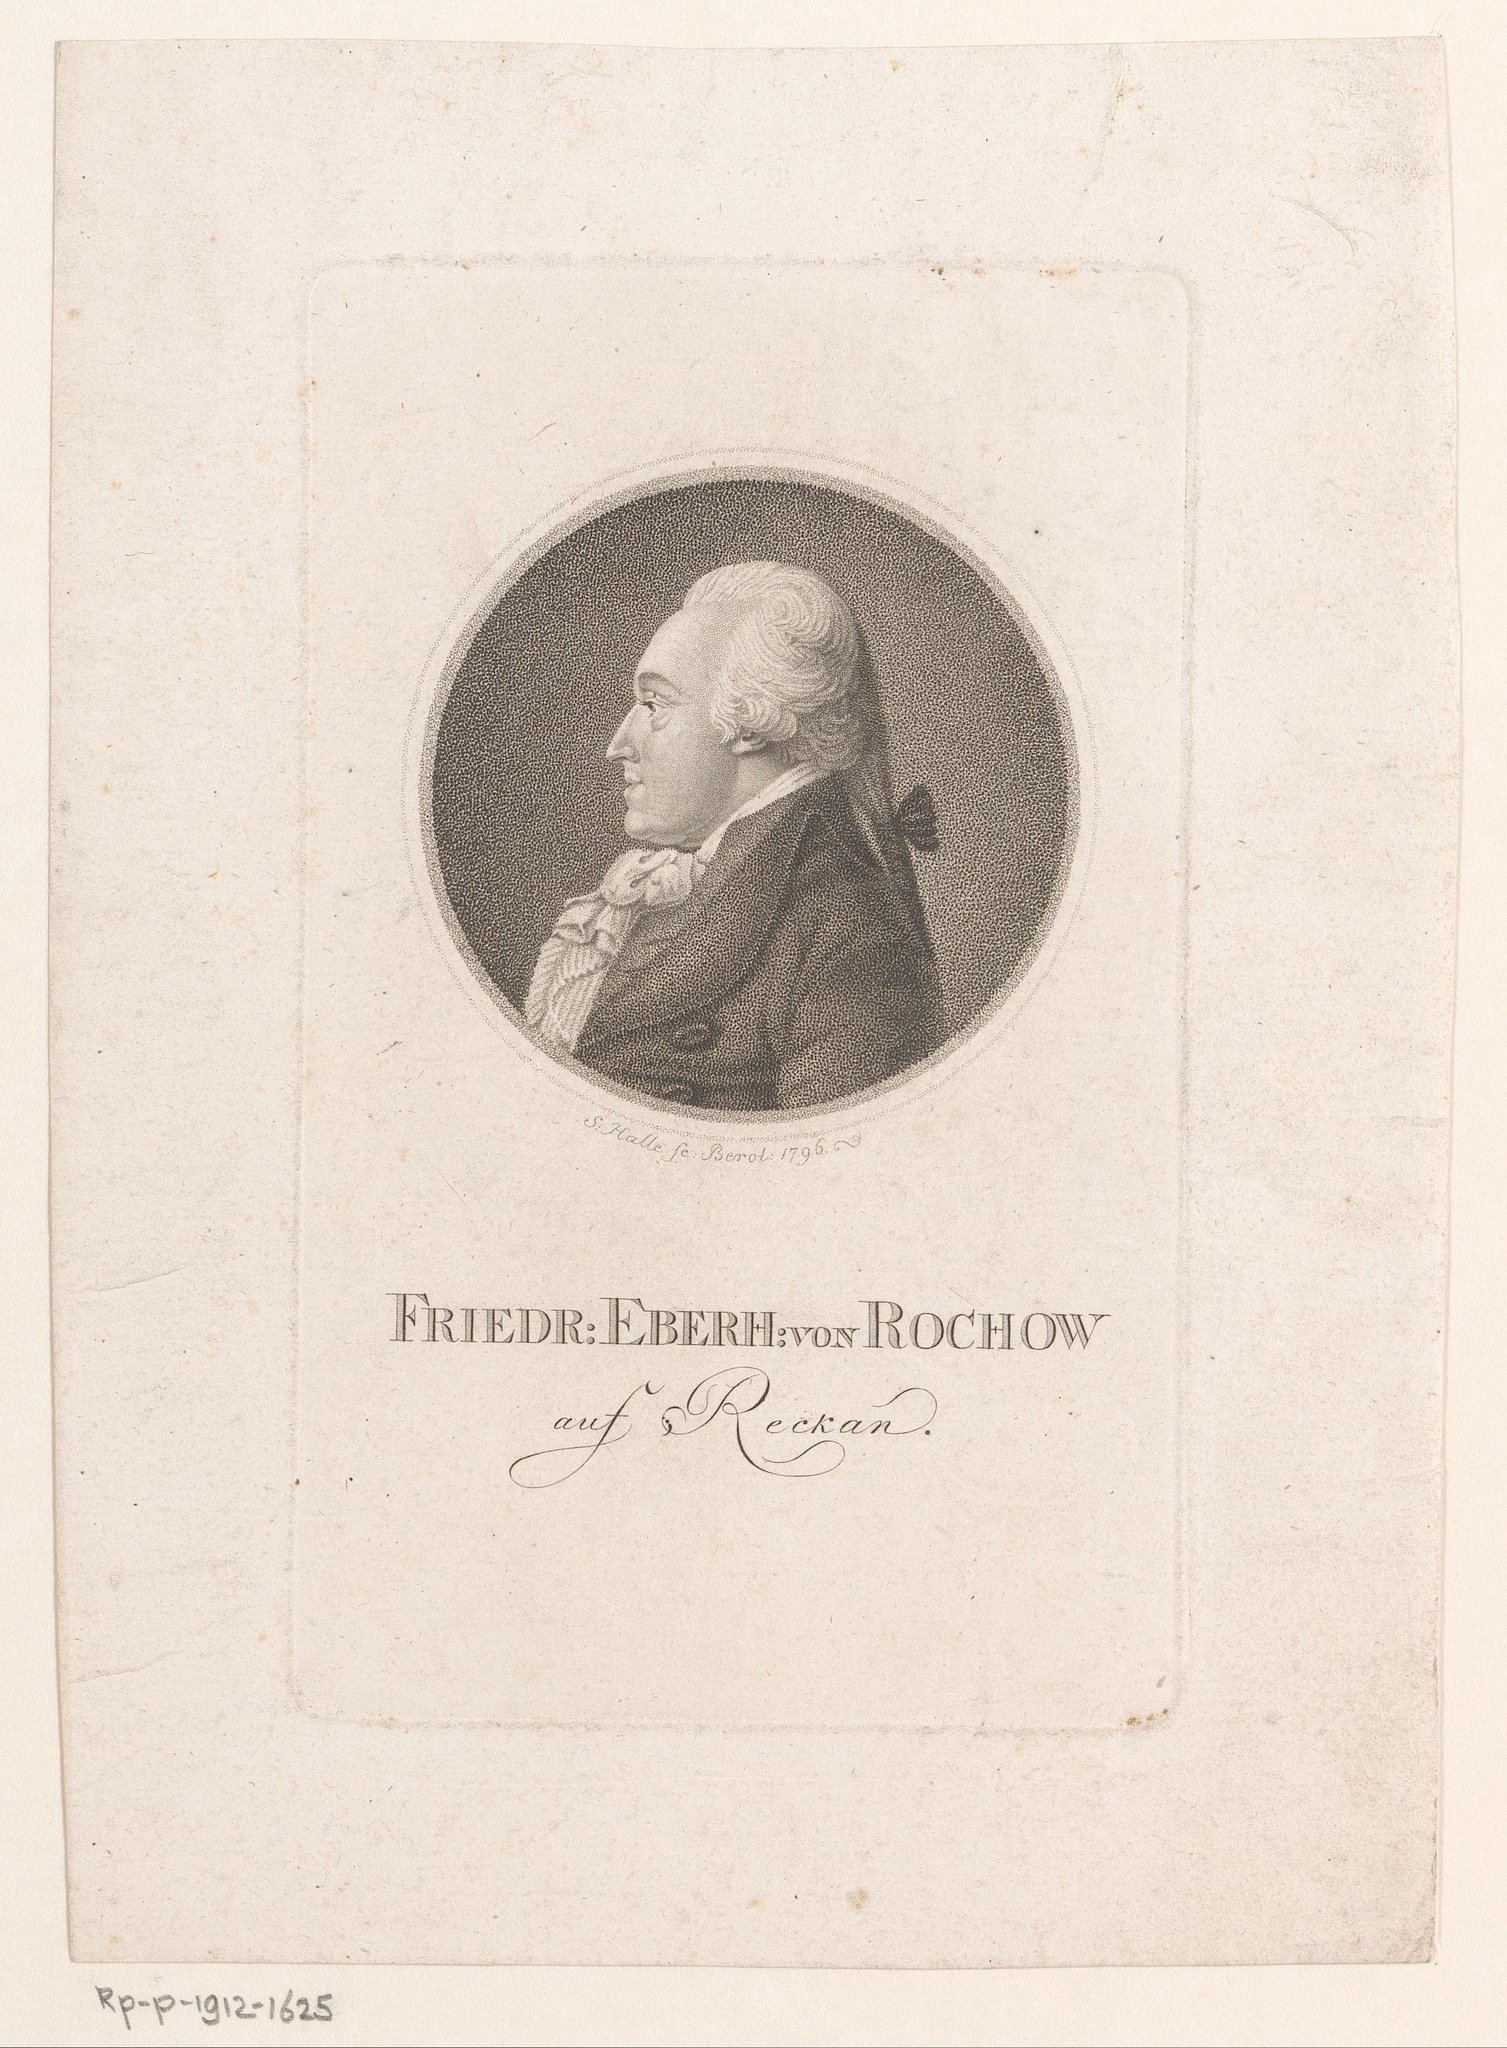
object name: print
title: Portret van Friedrich Eberhard von Rochow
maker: johann samuel ludwig halle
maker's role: print maker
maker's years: 1763-1829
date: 1796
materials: paper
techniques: stippling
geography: berlin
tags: berlin, historical persons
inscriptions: collector's mark: Lugt 2228